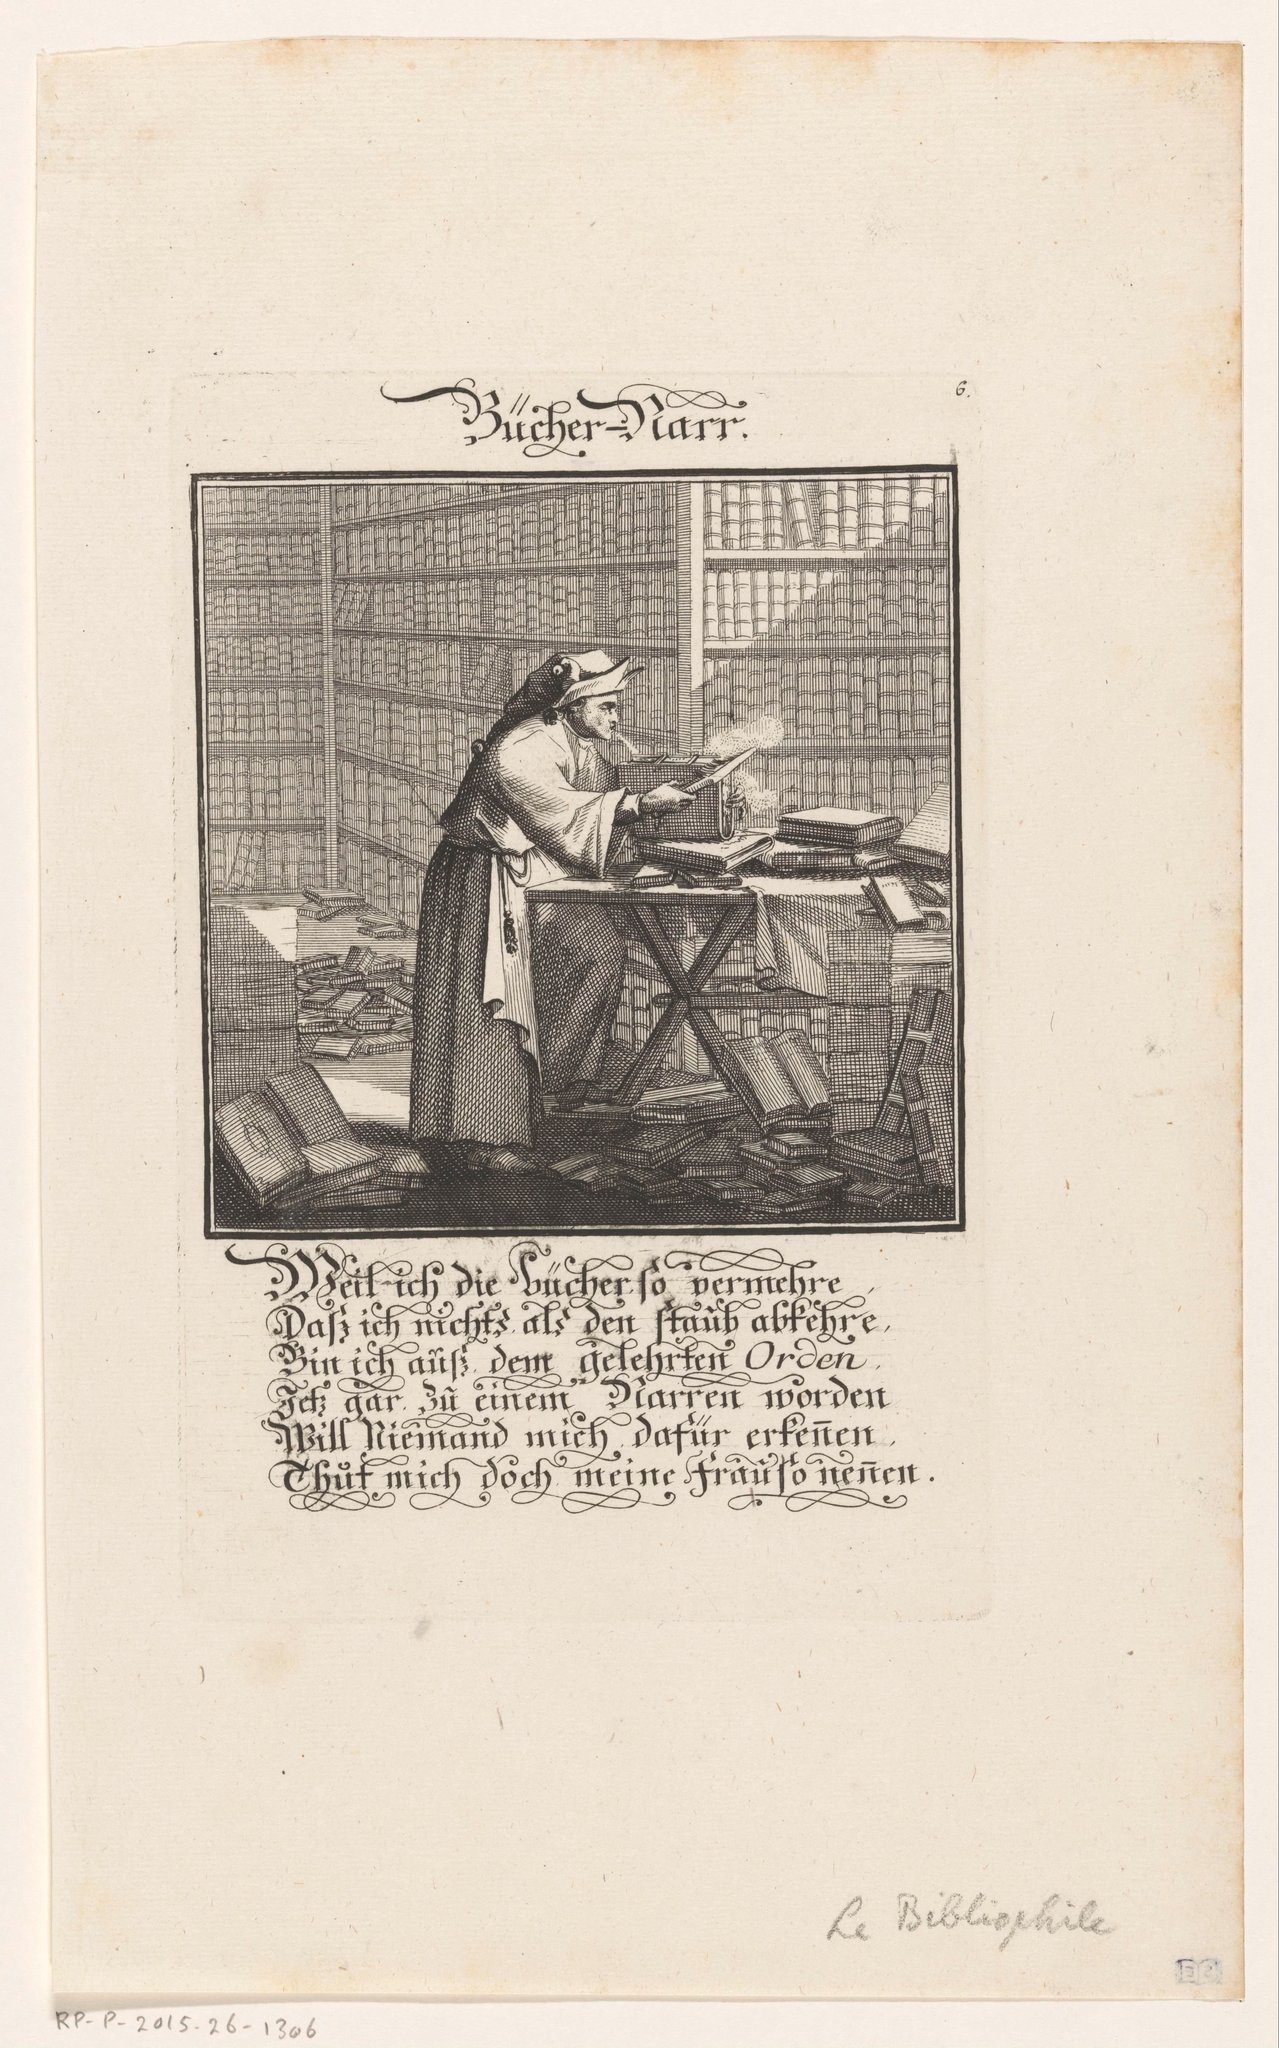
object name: print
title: Bücher-Narr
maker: christoph weigel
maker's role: goldsmith, print maker, publisher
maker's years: 1654-1725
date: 1709-1782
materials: paper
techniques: engraving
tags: study; 'studiolo'; library, book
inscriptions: collector's mark: Lugt 2228, collector's mark: Lugt 4780, watermark, collector's mark: Lugt 4779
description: Interieur van een studeervertrek met boekenkasten langs de wanden en boeken verspreid over de ruimte. Achter een tafel staat een man met een toga en een zotskap op het hoofd. Hij is bezig met het afstoffen van boeken.